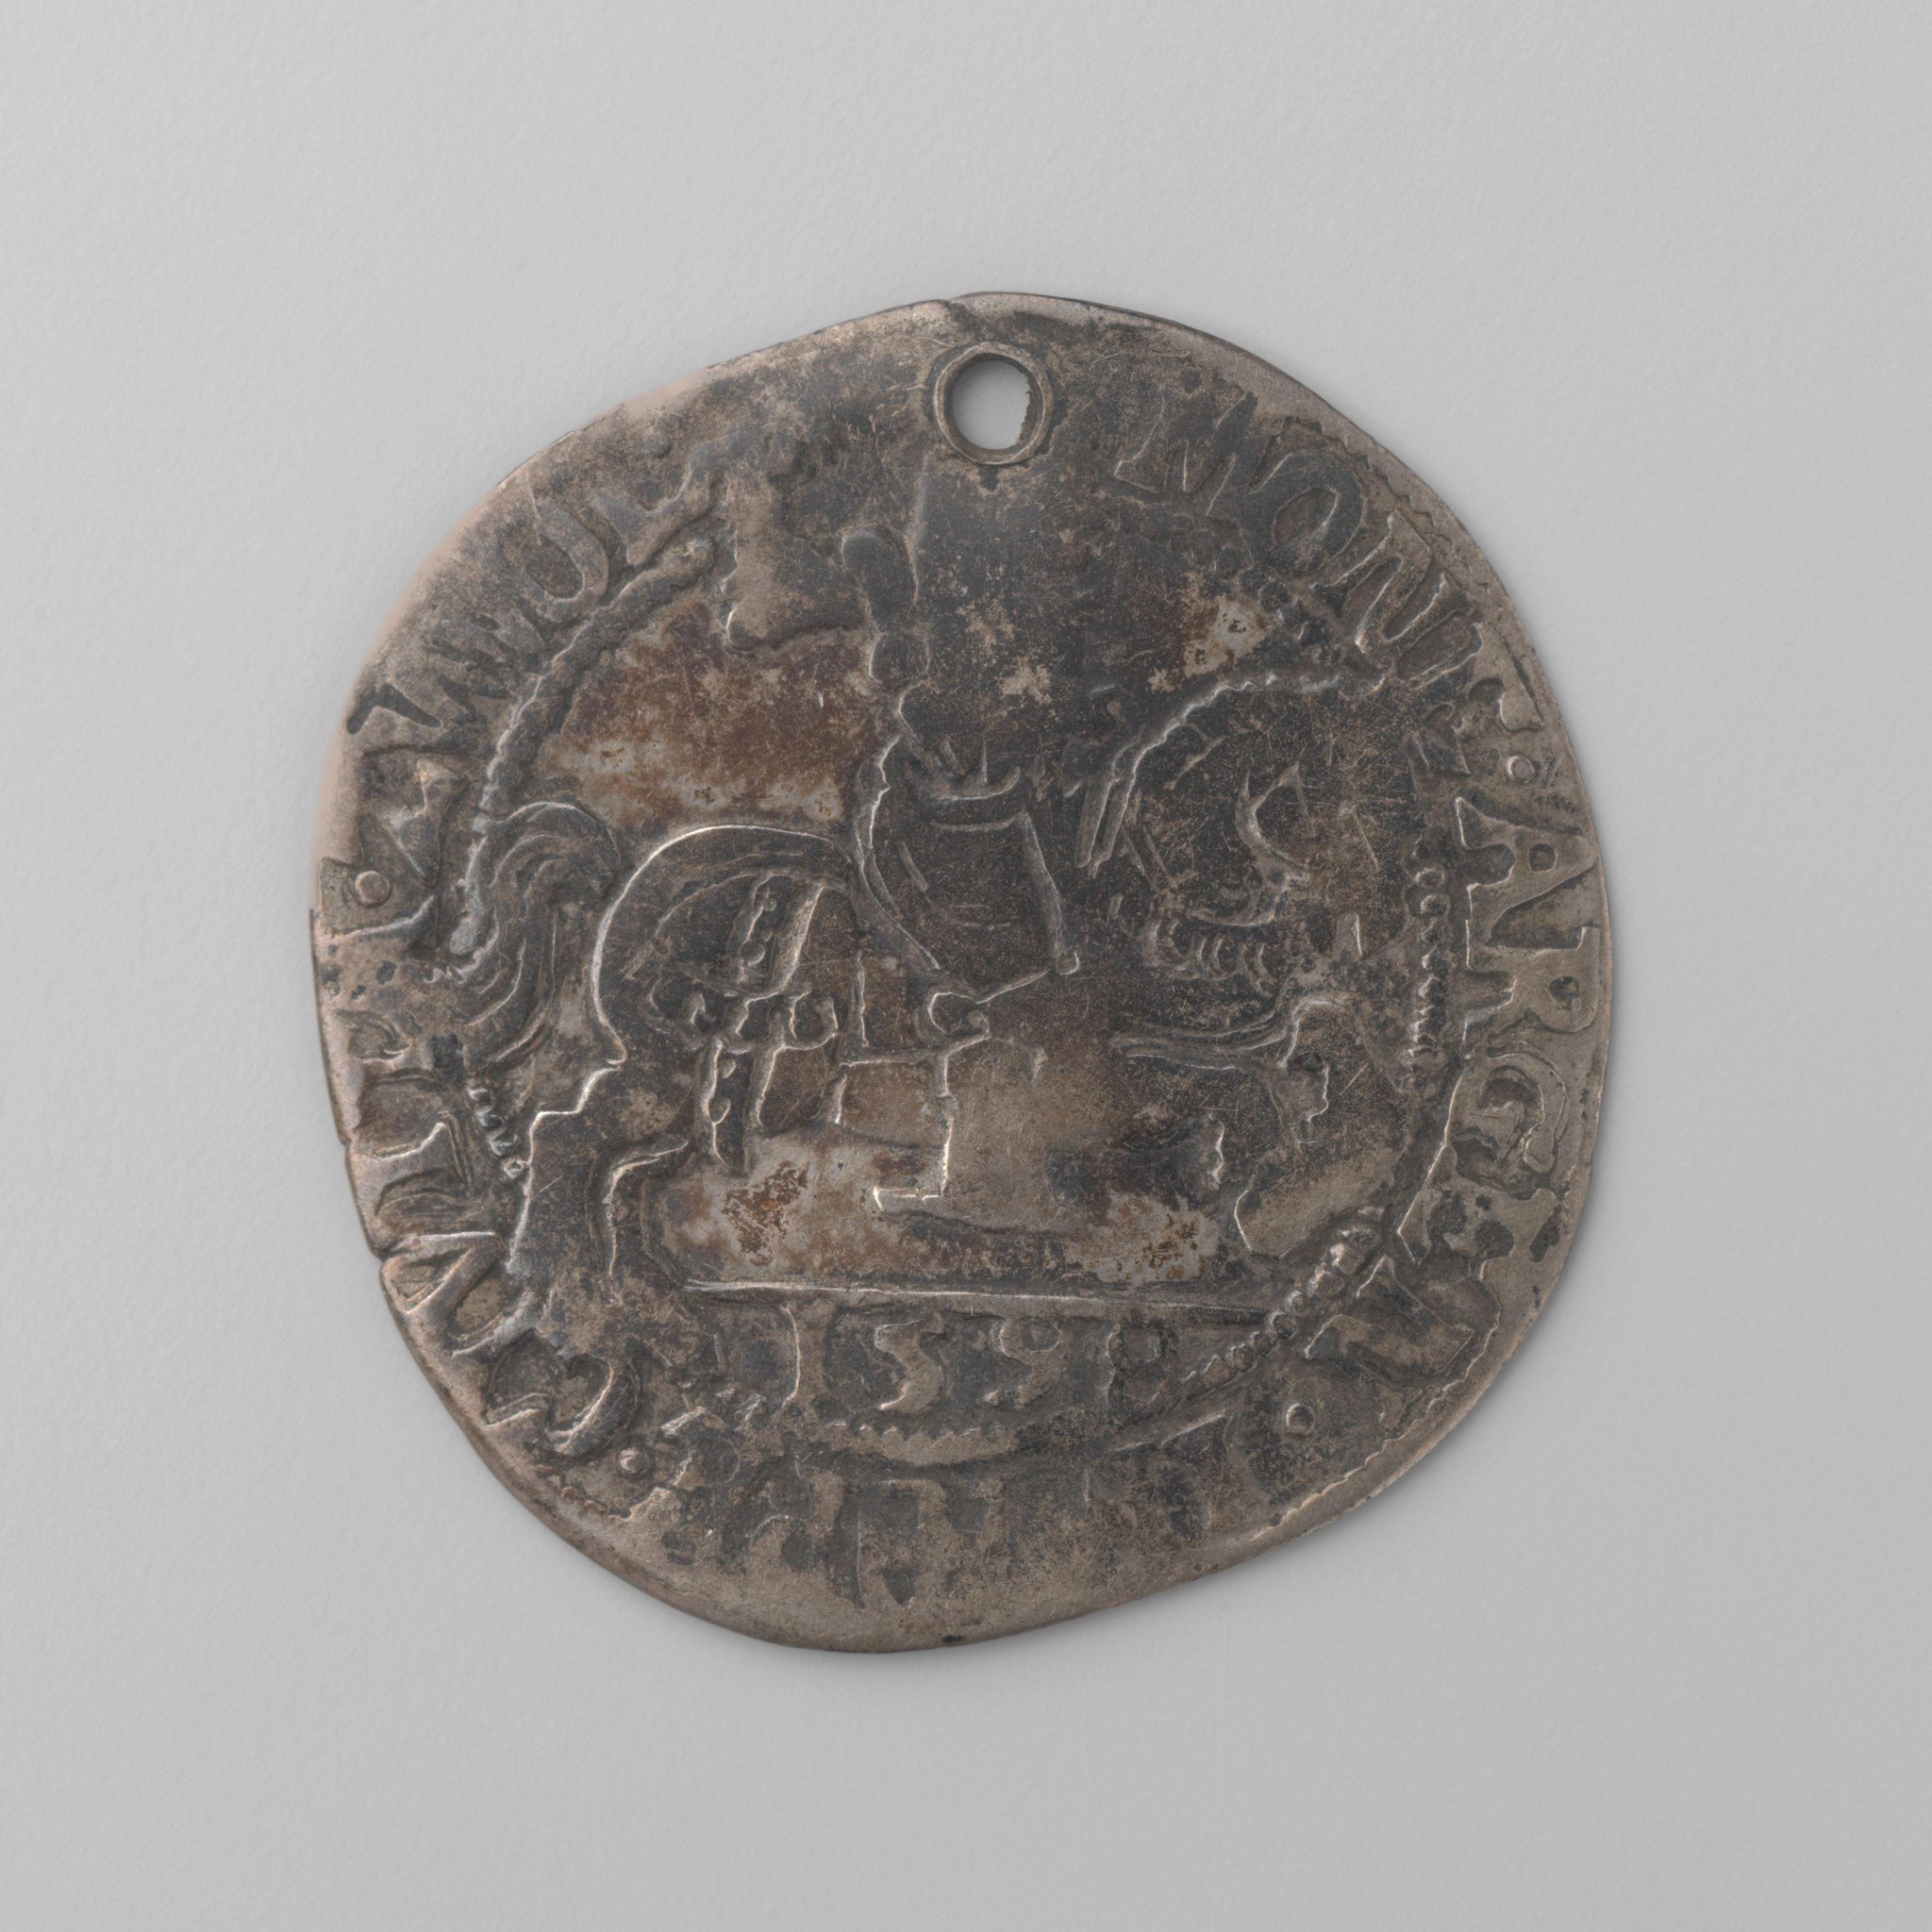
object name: coin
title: Overijsselse duit, 1764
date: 1764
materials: copper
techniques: striking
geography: kampen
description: Koperen munt. Voorzijde: tussen wapenspreuk gekroond provinciaal wapenschild. Keerzijde: tweeregelig opschrift, waarboven muntmeesterteken en waaronder jaartal.